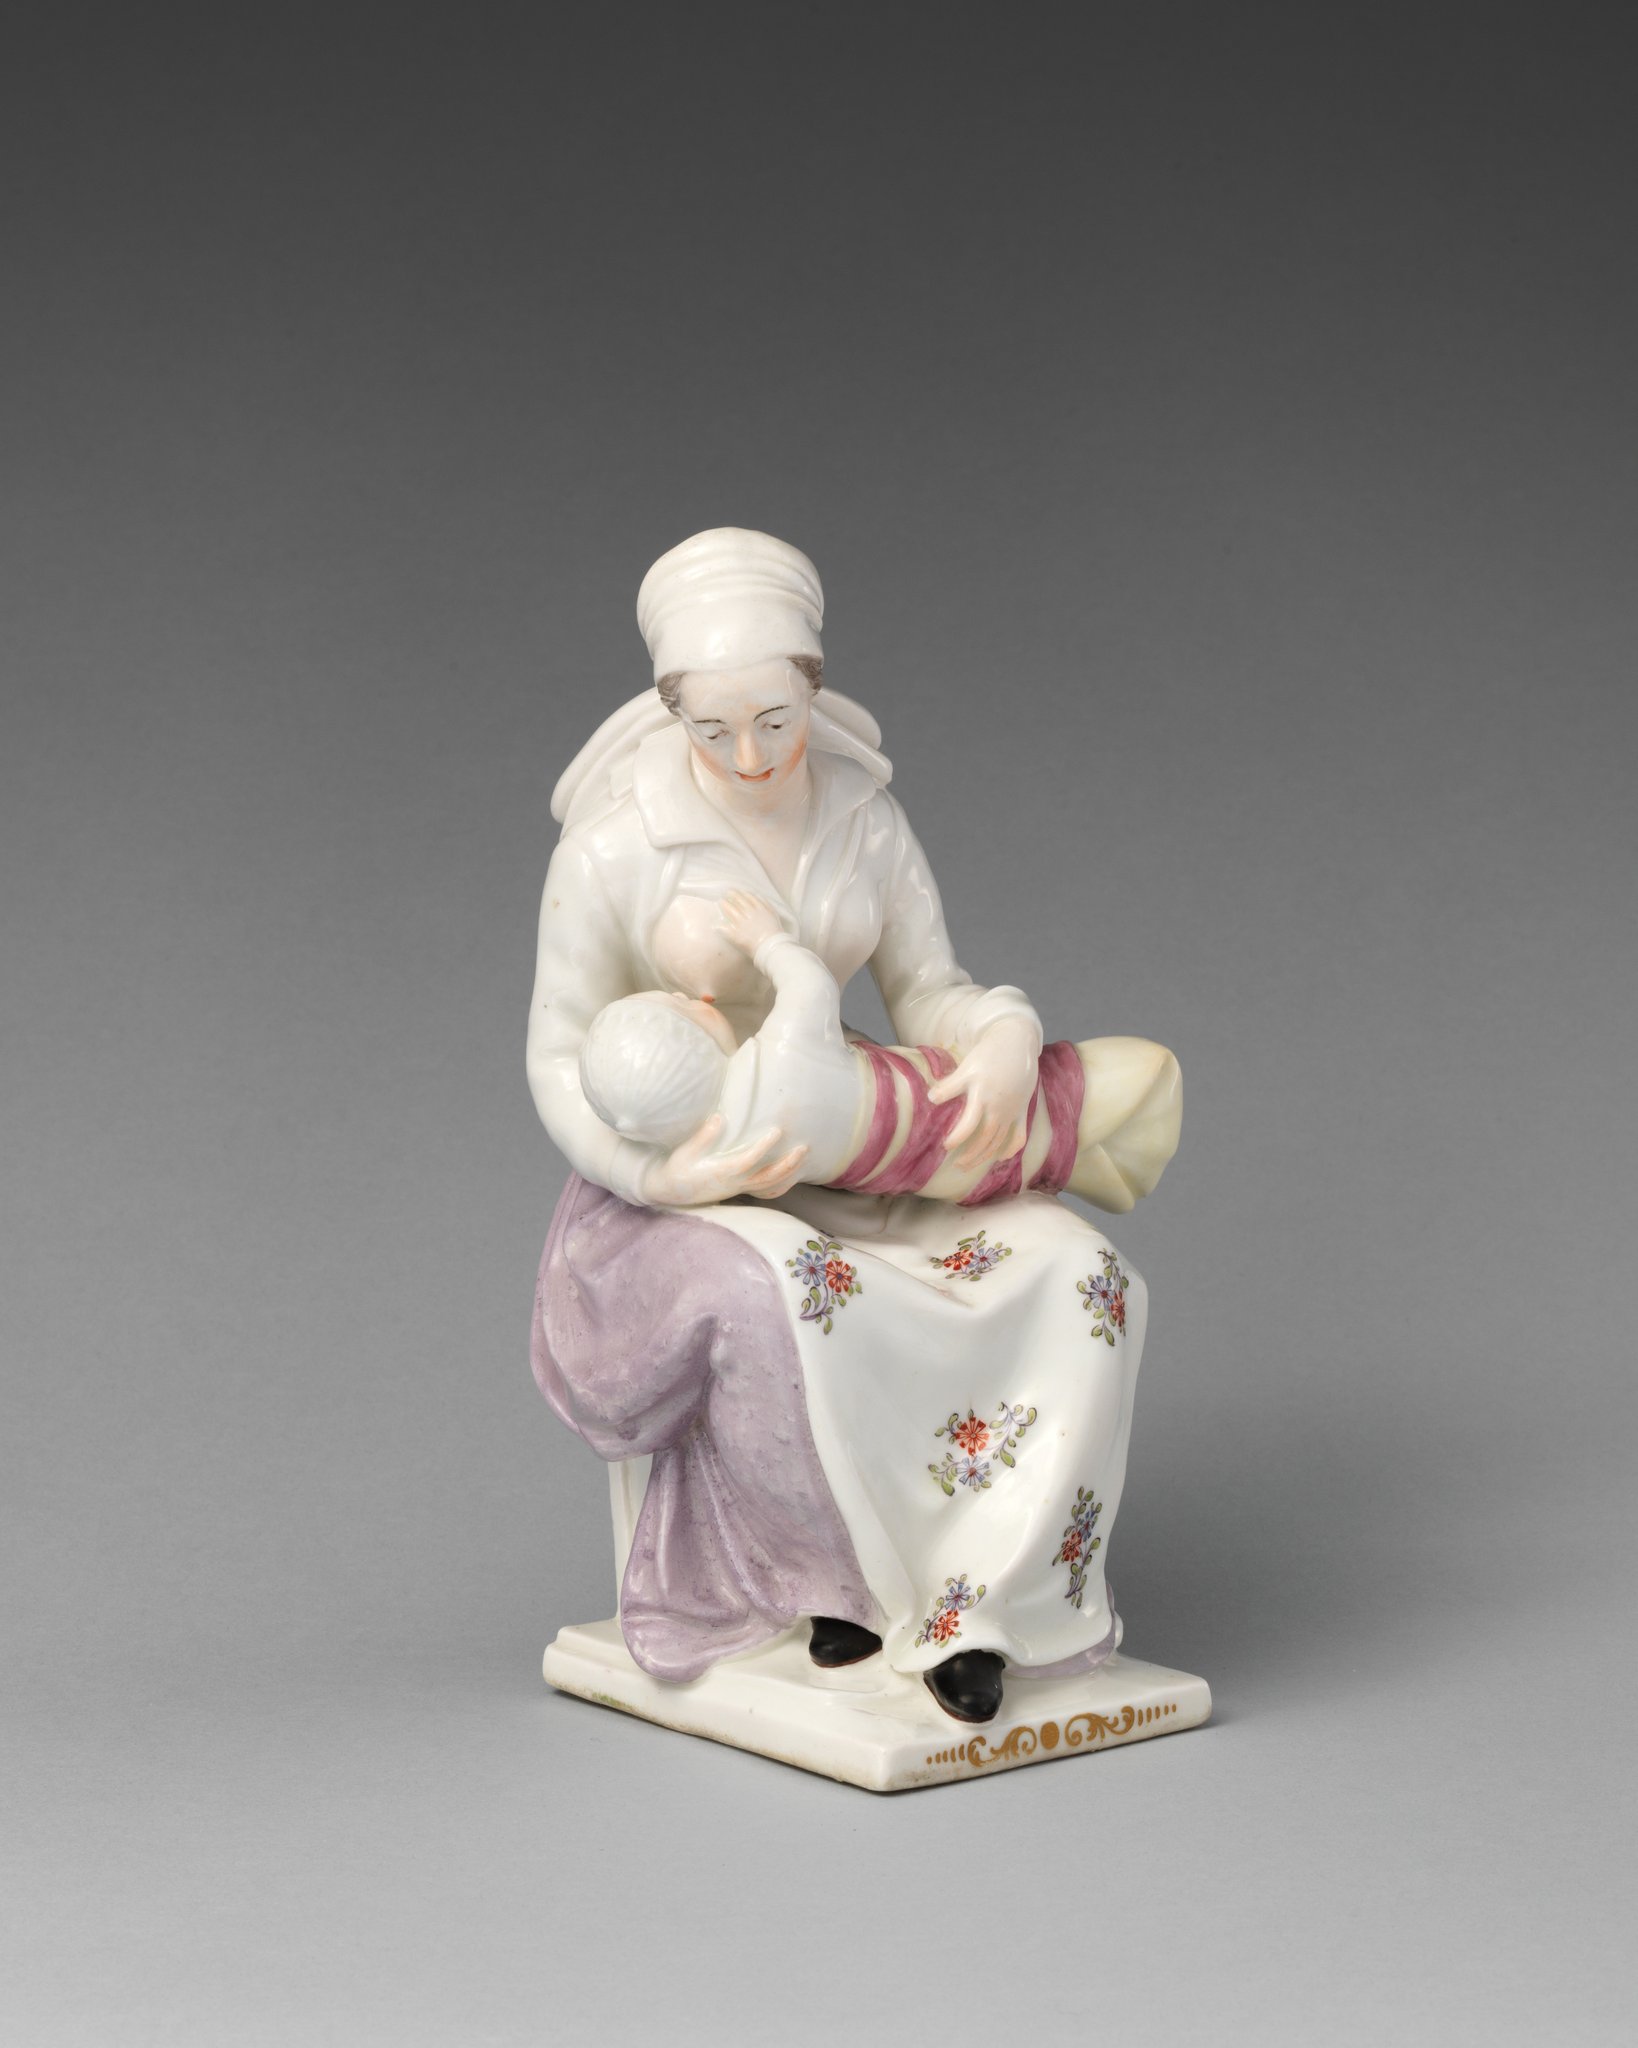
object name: figure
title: La Nourrice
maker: chelsea porcelain manufactory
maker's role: factory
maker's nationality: british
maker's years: 1744-1784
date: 1753-1755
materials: enamel, gold, soft paste porcelain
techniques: polychrome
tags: infants,mothers,women